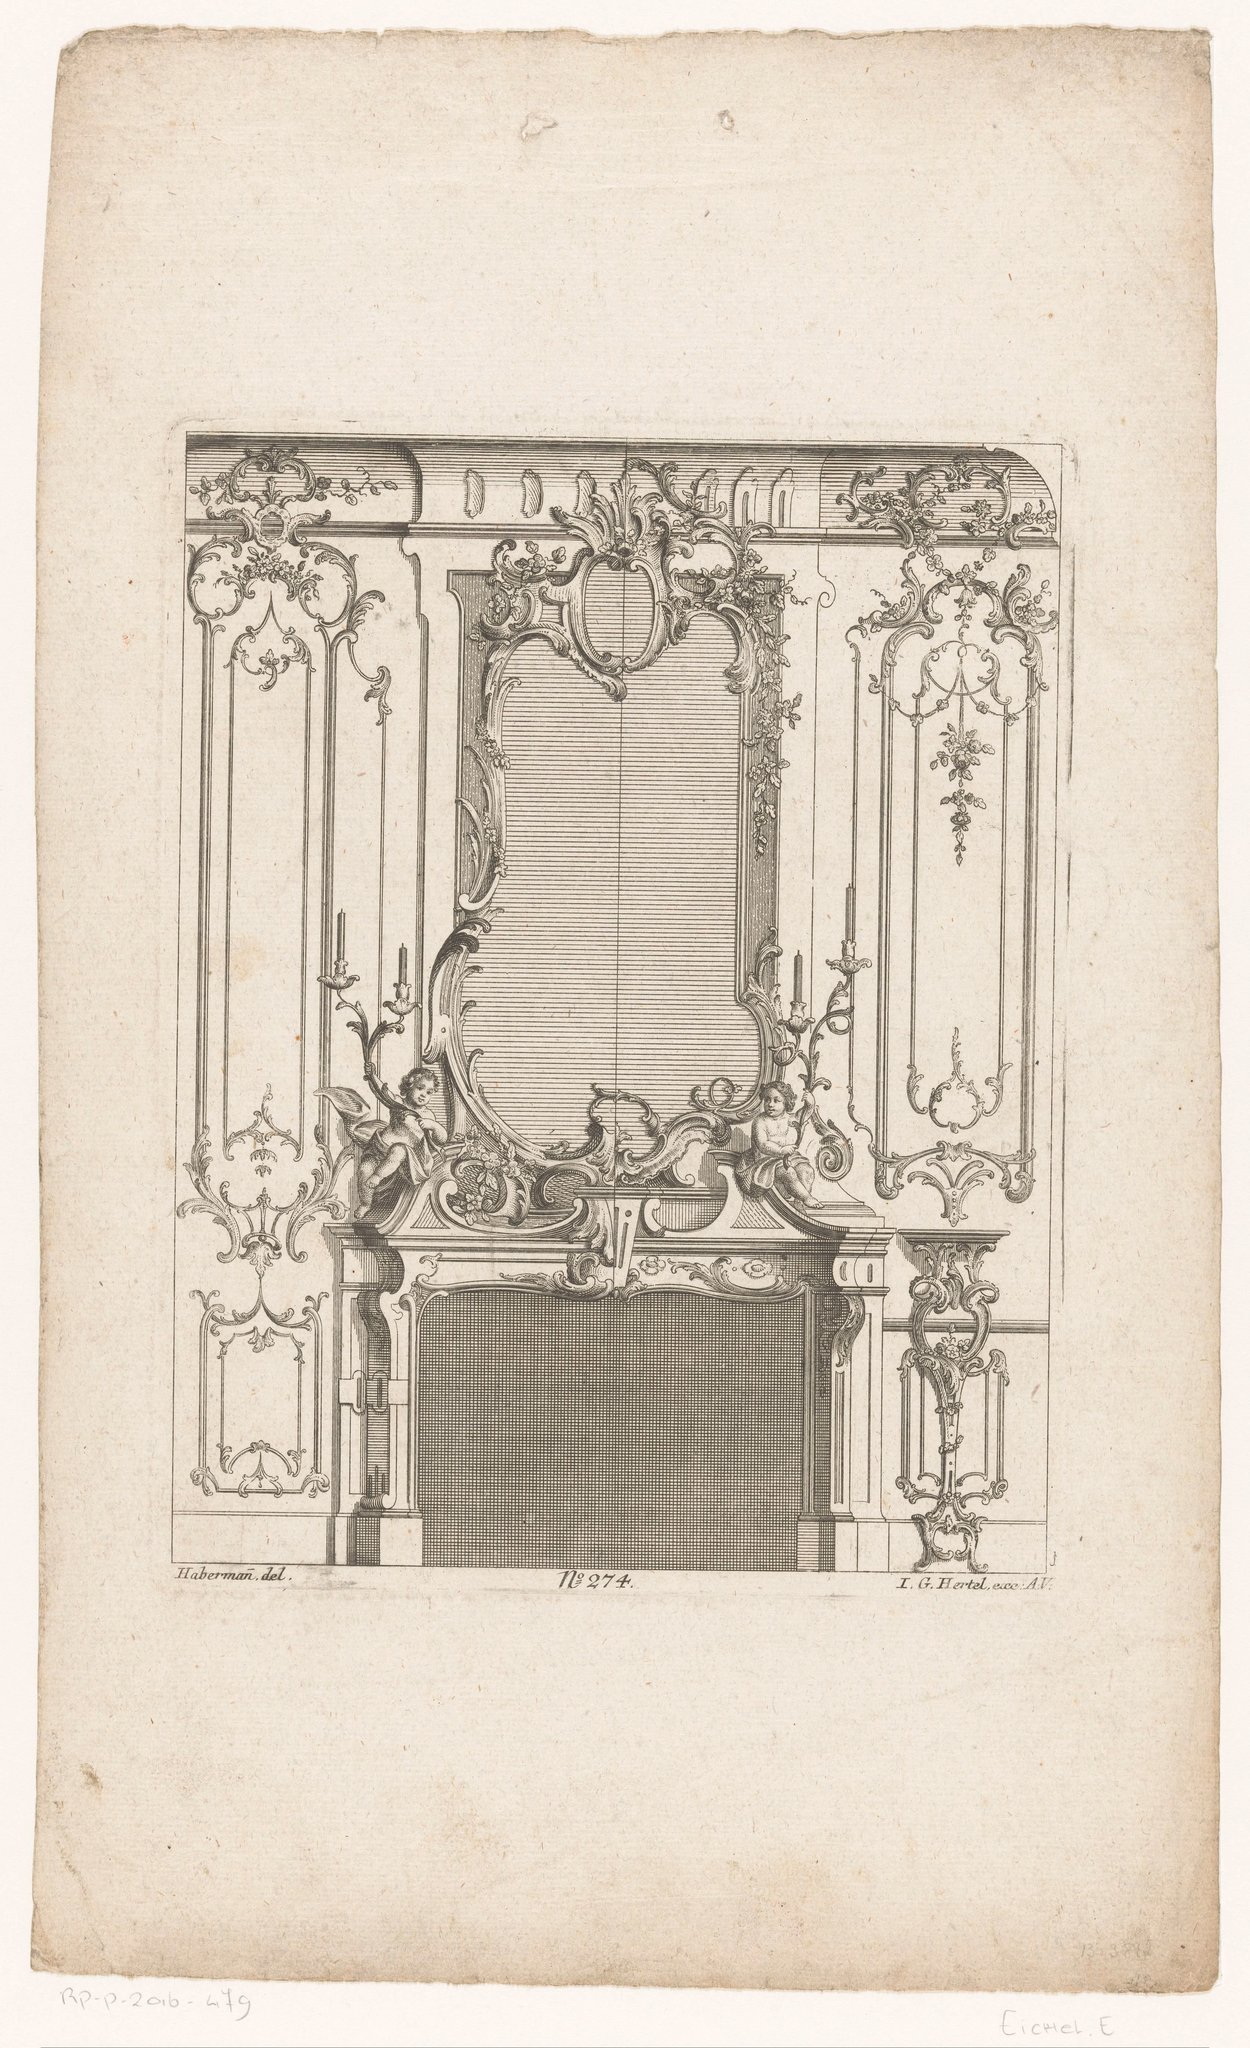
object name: print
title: Schouwen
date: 1746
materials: paper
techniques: engraving, etching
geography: augsburg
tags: chandelier, candelabrum, open hearth, fire-place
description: Schouw met rocaille ornamenten, twee tweearmige kandelaars en twee putti. Uitgeversnummer 274.